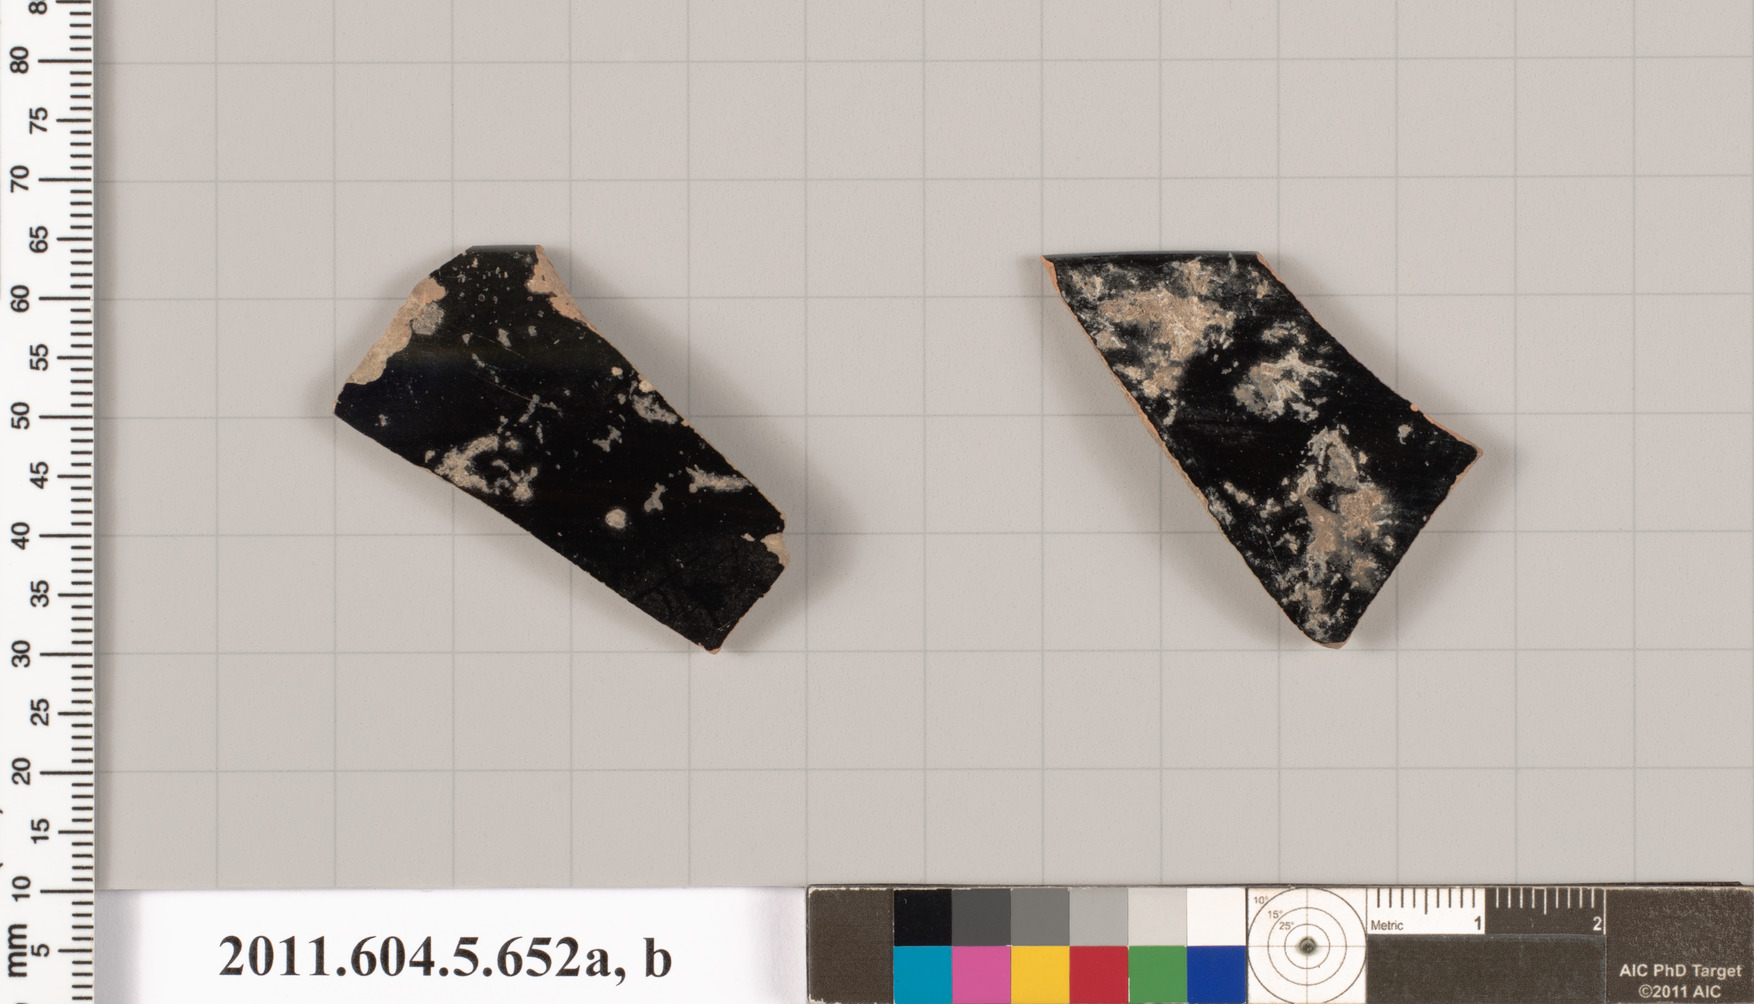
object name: kylix fragment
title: Terracotta rim fragments of kylikes (drinking cups)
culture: greek, attic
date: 600-401 BCE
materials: terracotta